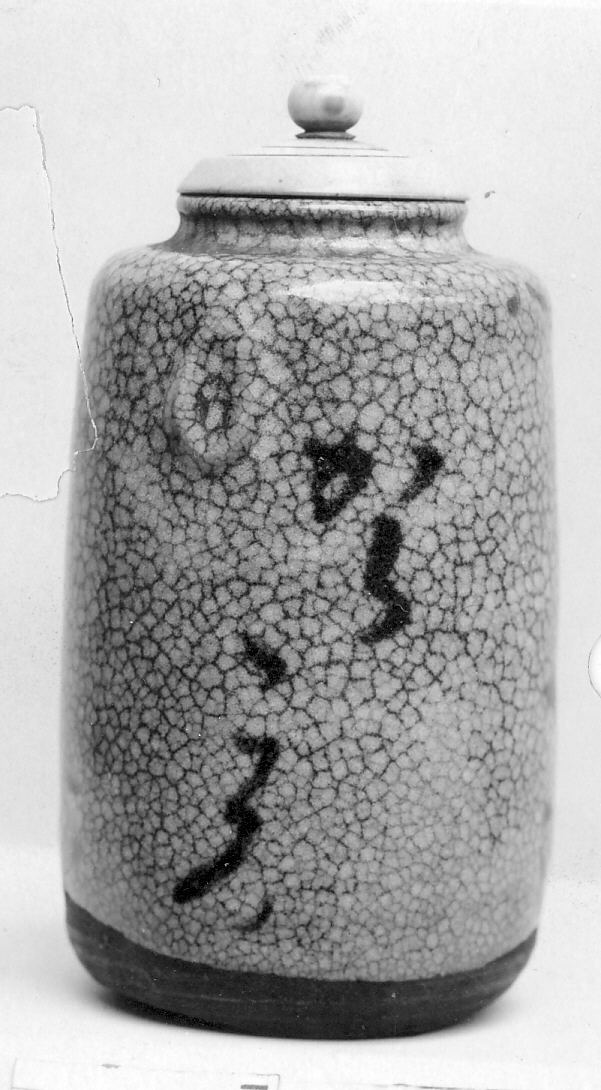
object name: tea jar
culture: japanese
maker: shino ienobu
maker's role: artist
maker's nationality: japanese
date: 1480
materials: clay, ivory